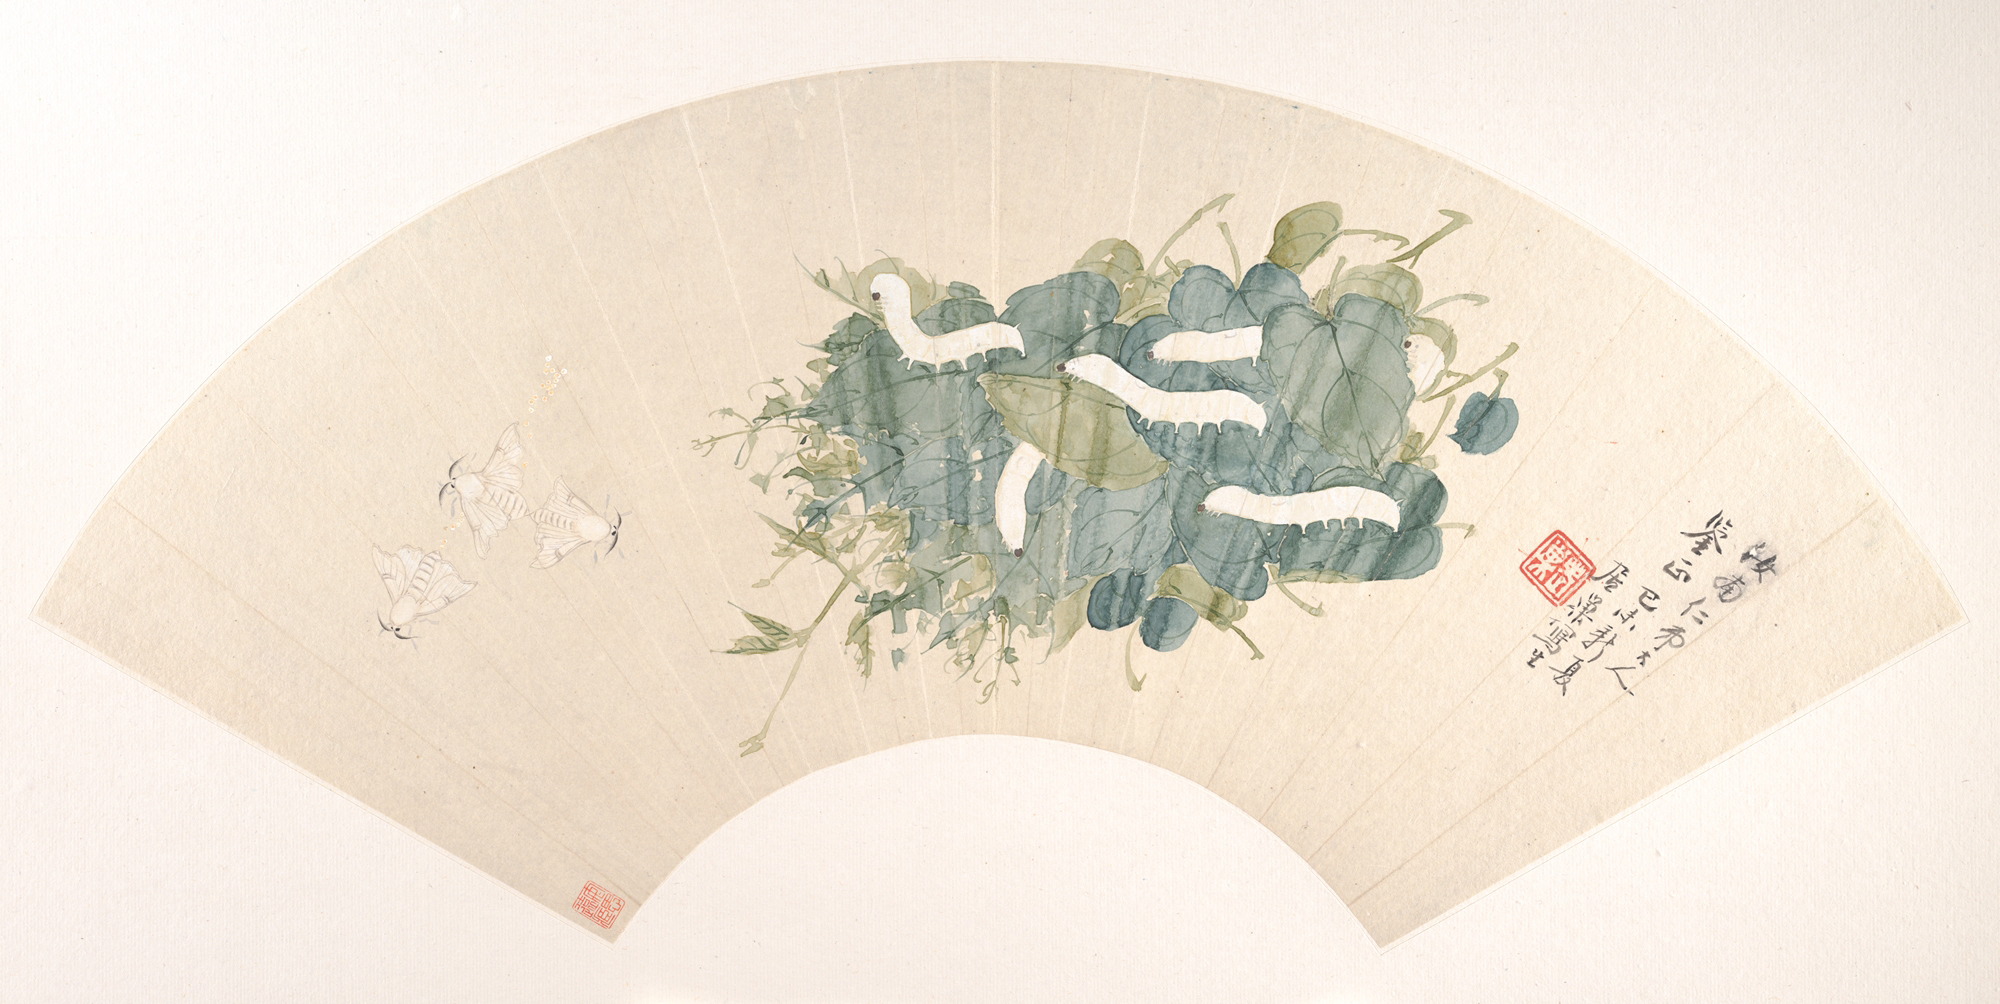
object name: folding fan mounted a an album leaf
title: Silkworm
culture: chinese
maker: ju chao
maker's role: artist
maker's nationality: chinese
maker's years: 1823-1889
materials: ink, paper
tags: insects